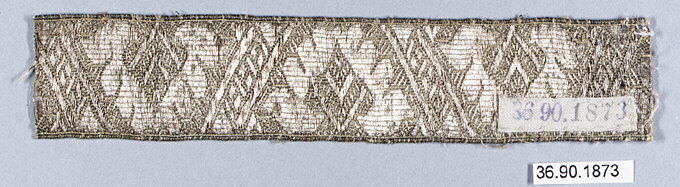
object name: galloon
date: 1801-1900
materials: metal thread, silk